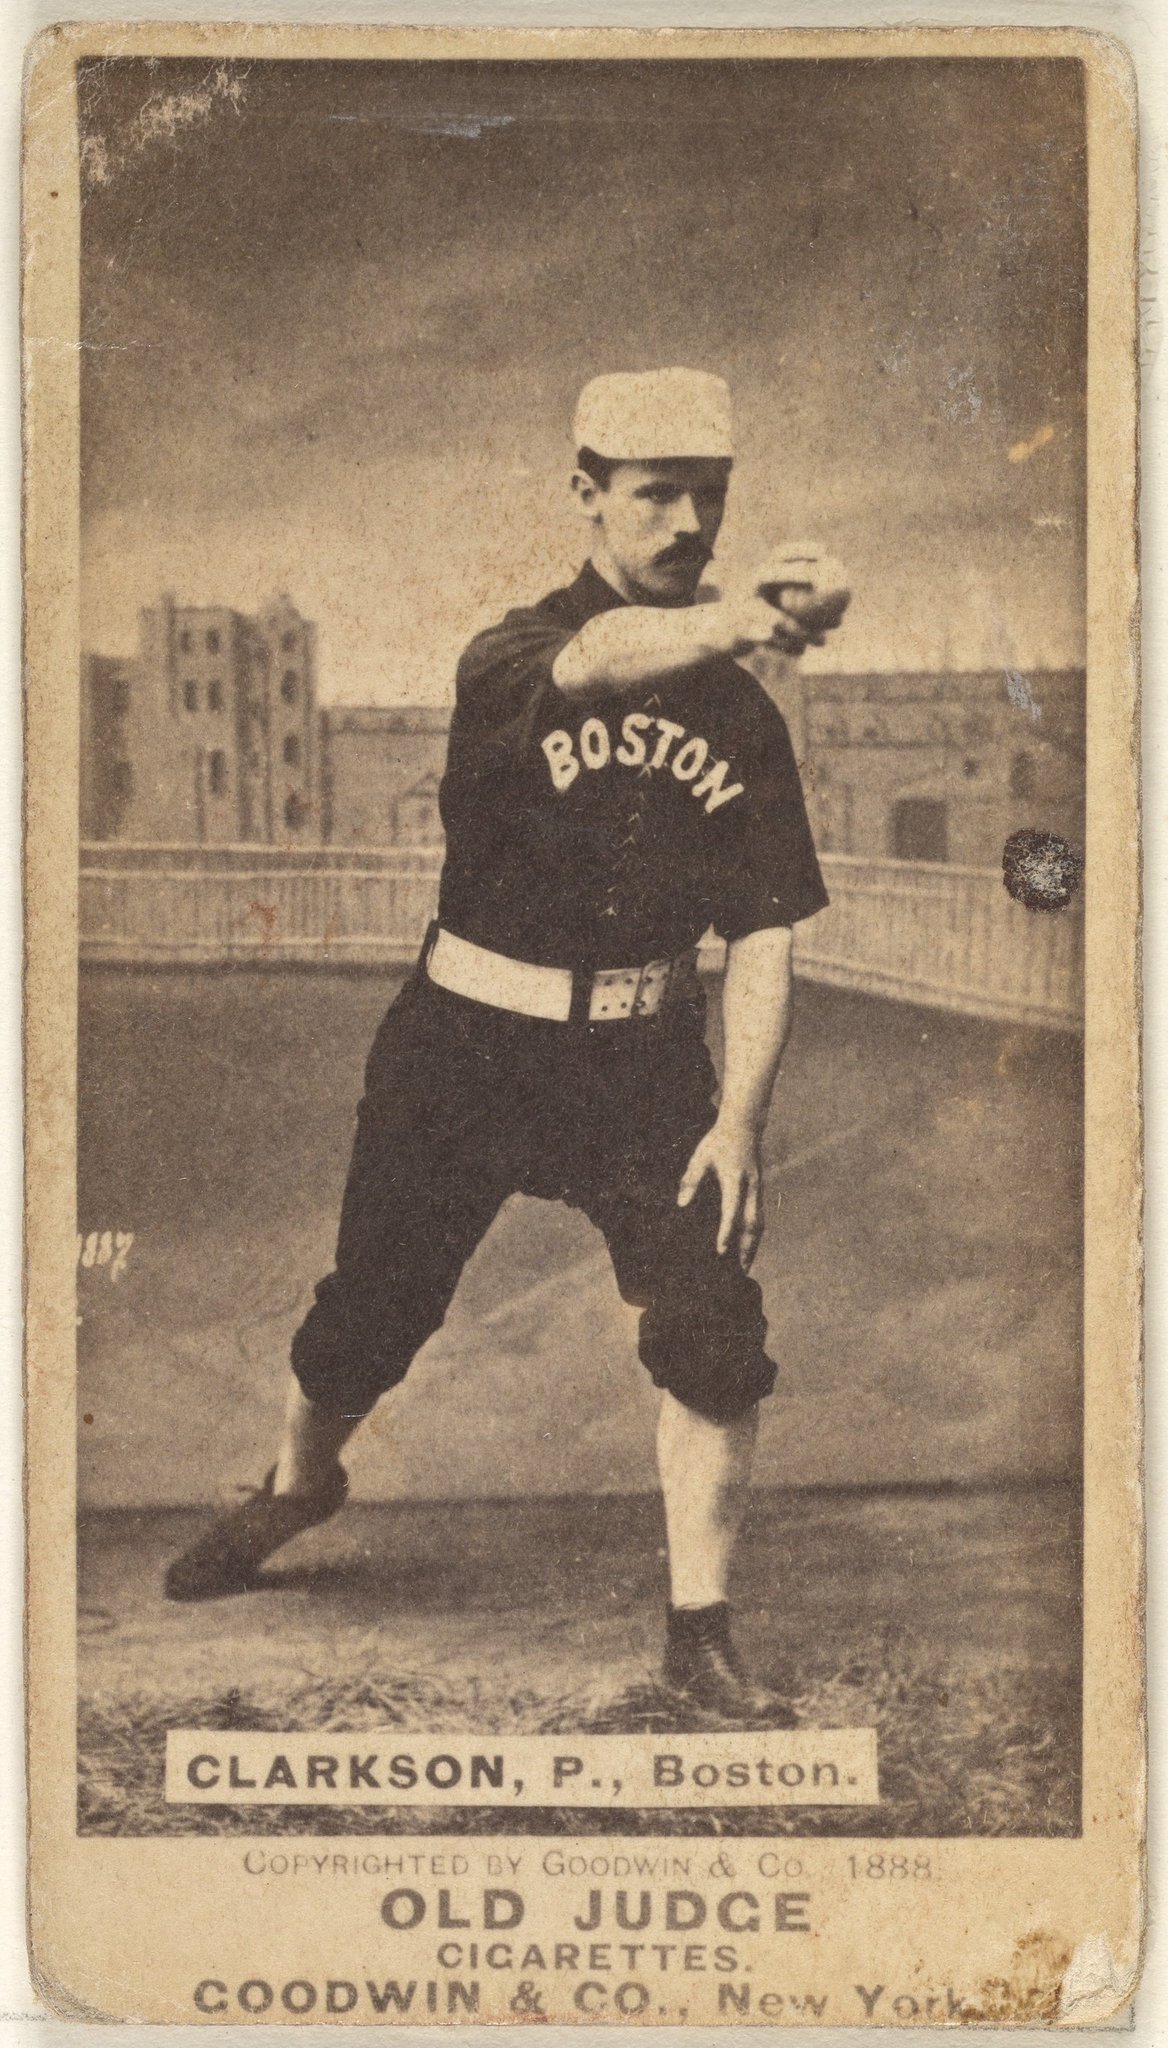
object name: baseball card, photograph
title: Clarkson, Pitcher, Boston, from the Old Judge series (N172) for Old Judge Cigarettes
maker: goodwin & company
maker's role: publisher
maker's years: 1850-1950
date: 1888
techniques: albumen silver print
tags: men,portraits,baseball,athletes